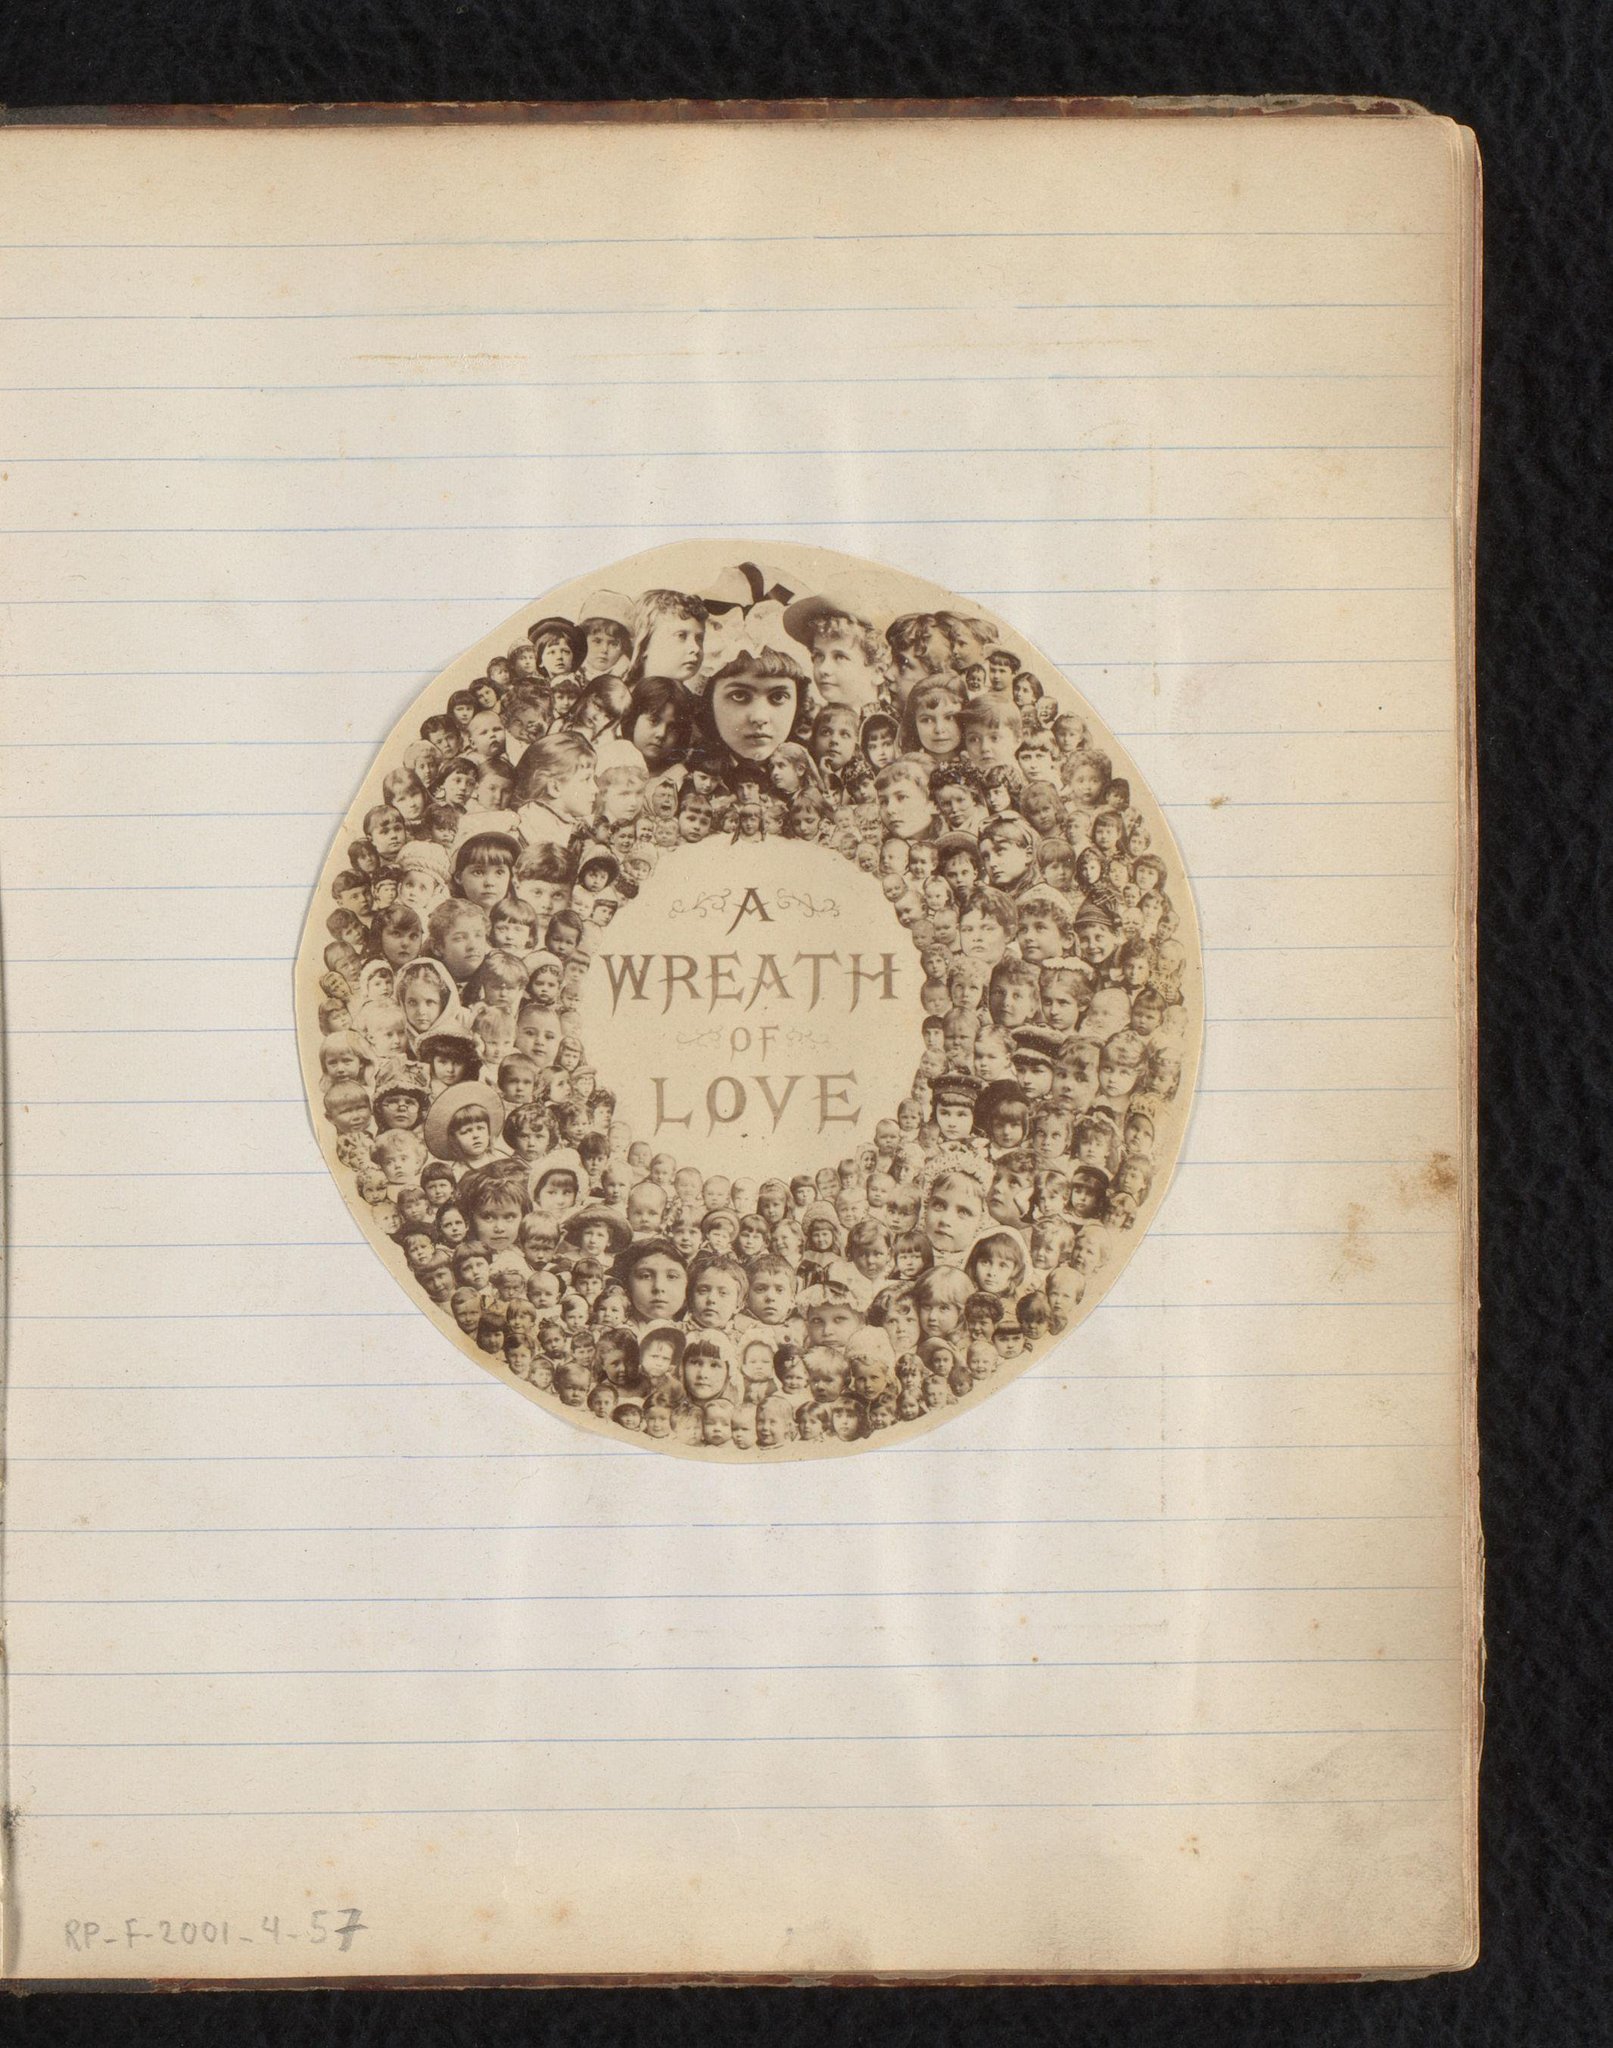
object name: photograph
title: Compositieportret van kinderkopjes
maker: Anonymous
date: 1885-1895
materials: photographic support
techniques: albumen print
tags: head (human), child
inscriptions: title: ‘A Wreath of Love’